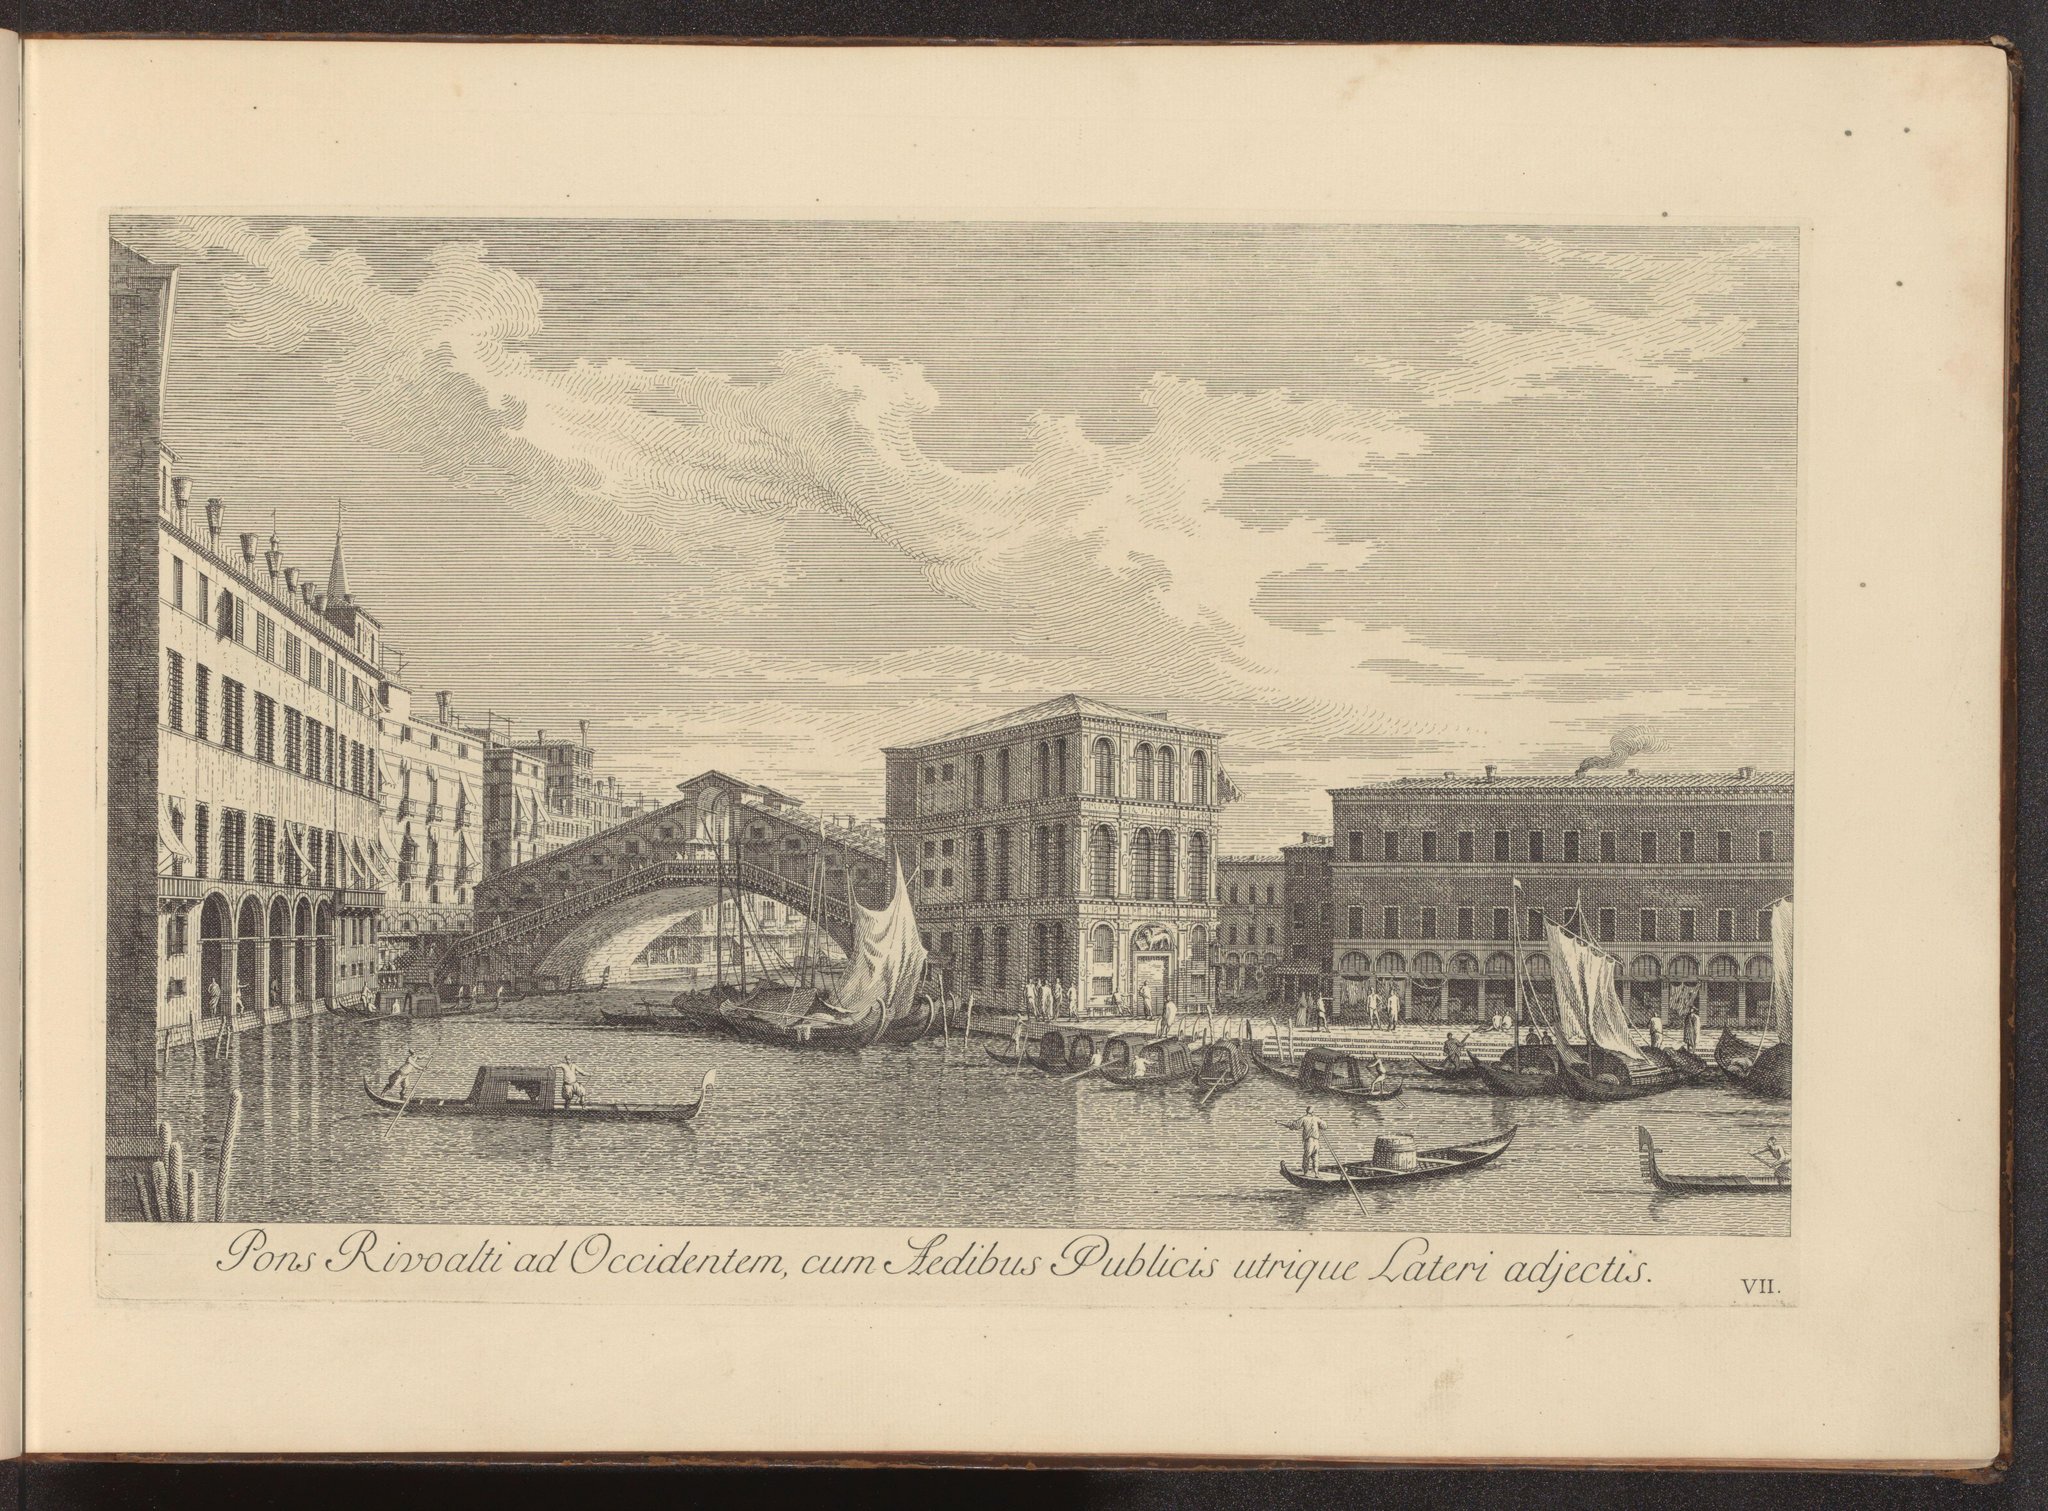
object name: album leaf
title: Pons Rivoalti ad Occidentem, cum Aedibus Publicis utrique Lateri adjectis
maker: antonio visentini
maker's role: draughtsman, print maker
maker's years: 1688-1782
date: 1742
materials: paper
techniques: etching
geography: venice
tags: city-view, and landscape with man-made constructions, canal